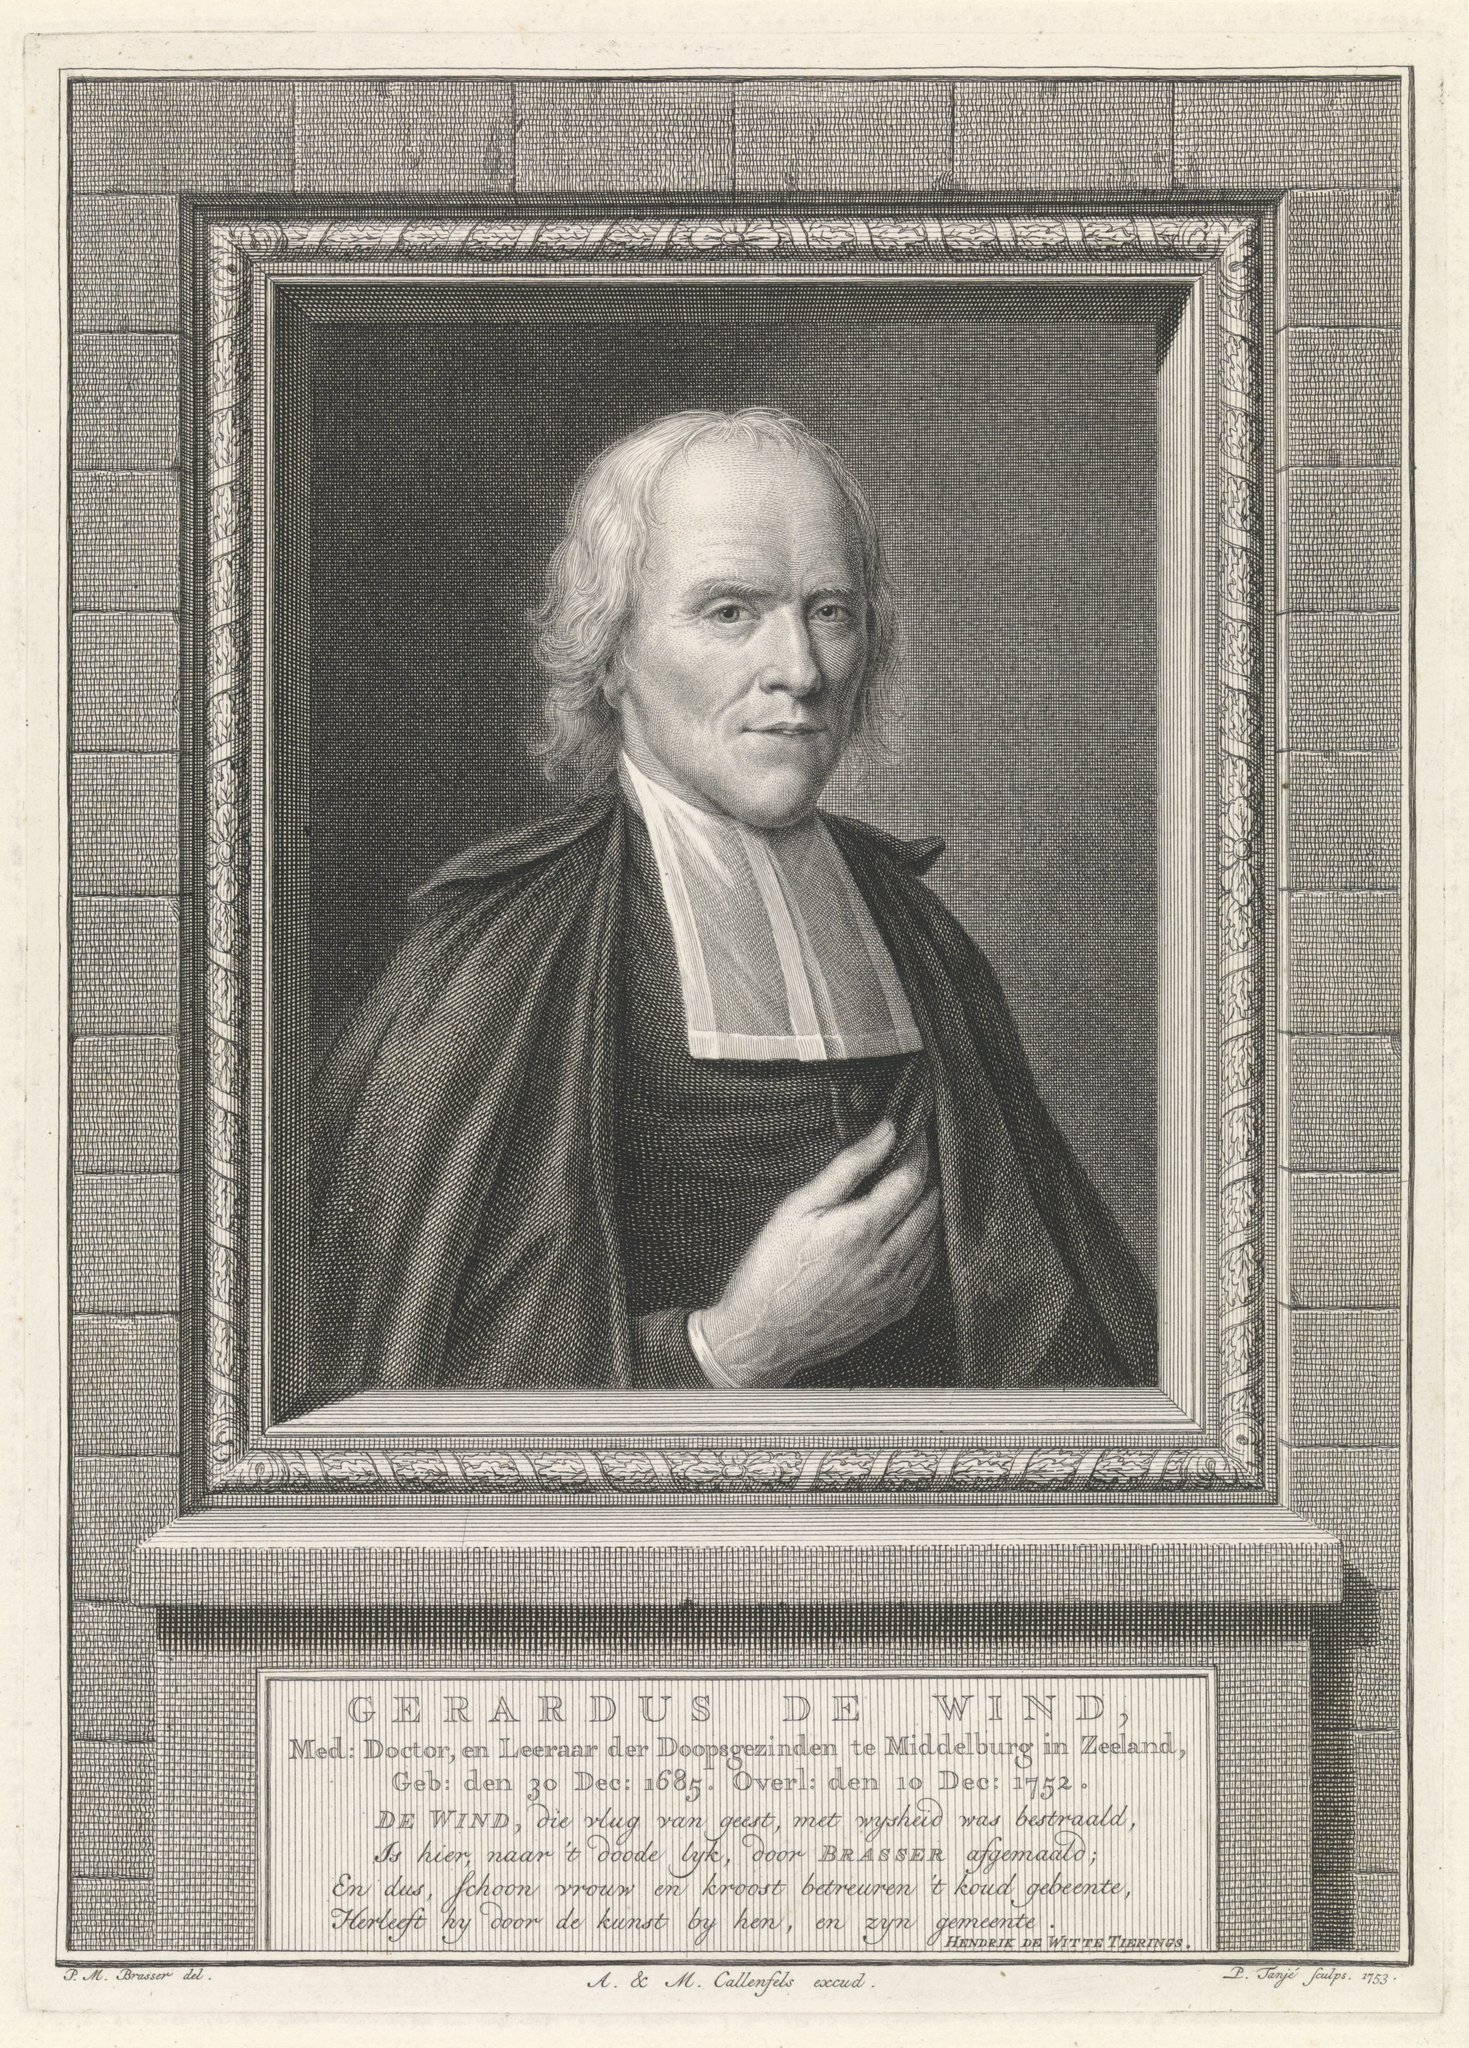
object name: print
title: Portret van Gerardus de Wind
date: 1753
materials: paper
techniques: engraving, etching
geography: middelburg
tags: middelburg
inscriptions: collector's mark: Lugt 240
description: Portret van Gerardus de Wind, arts en doopsgezind predikant te Middelburg. Onder het portret zijn geboort- en sterfdata en een vierregelig vers in het Nederlands.